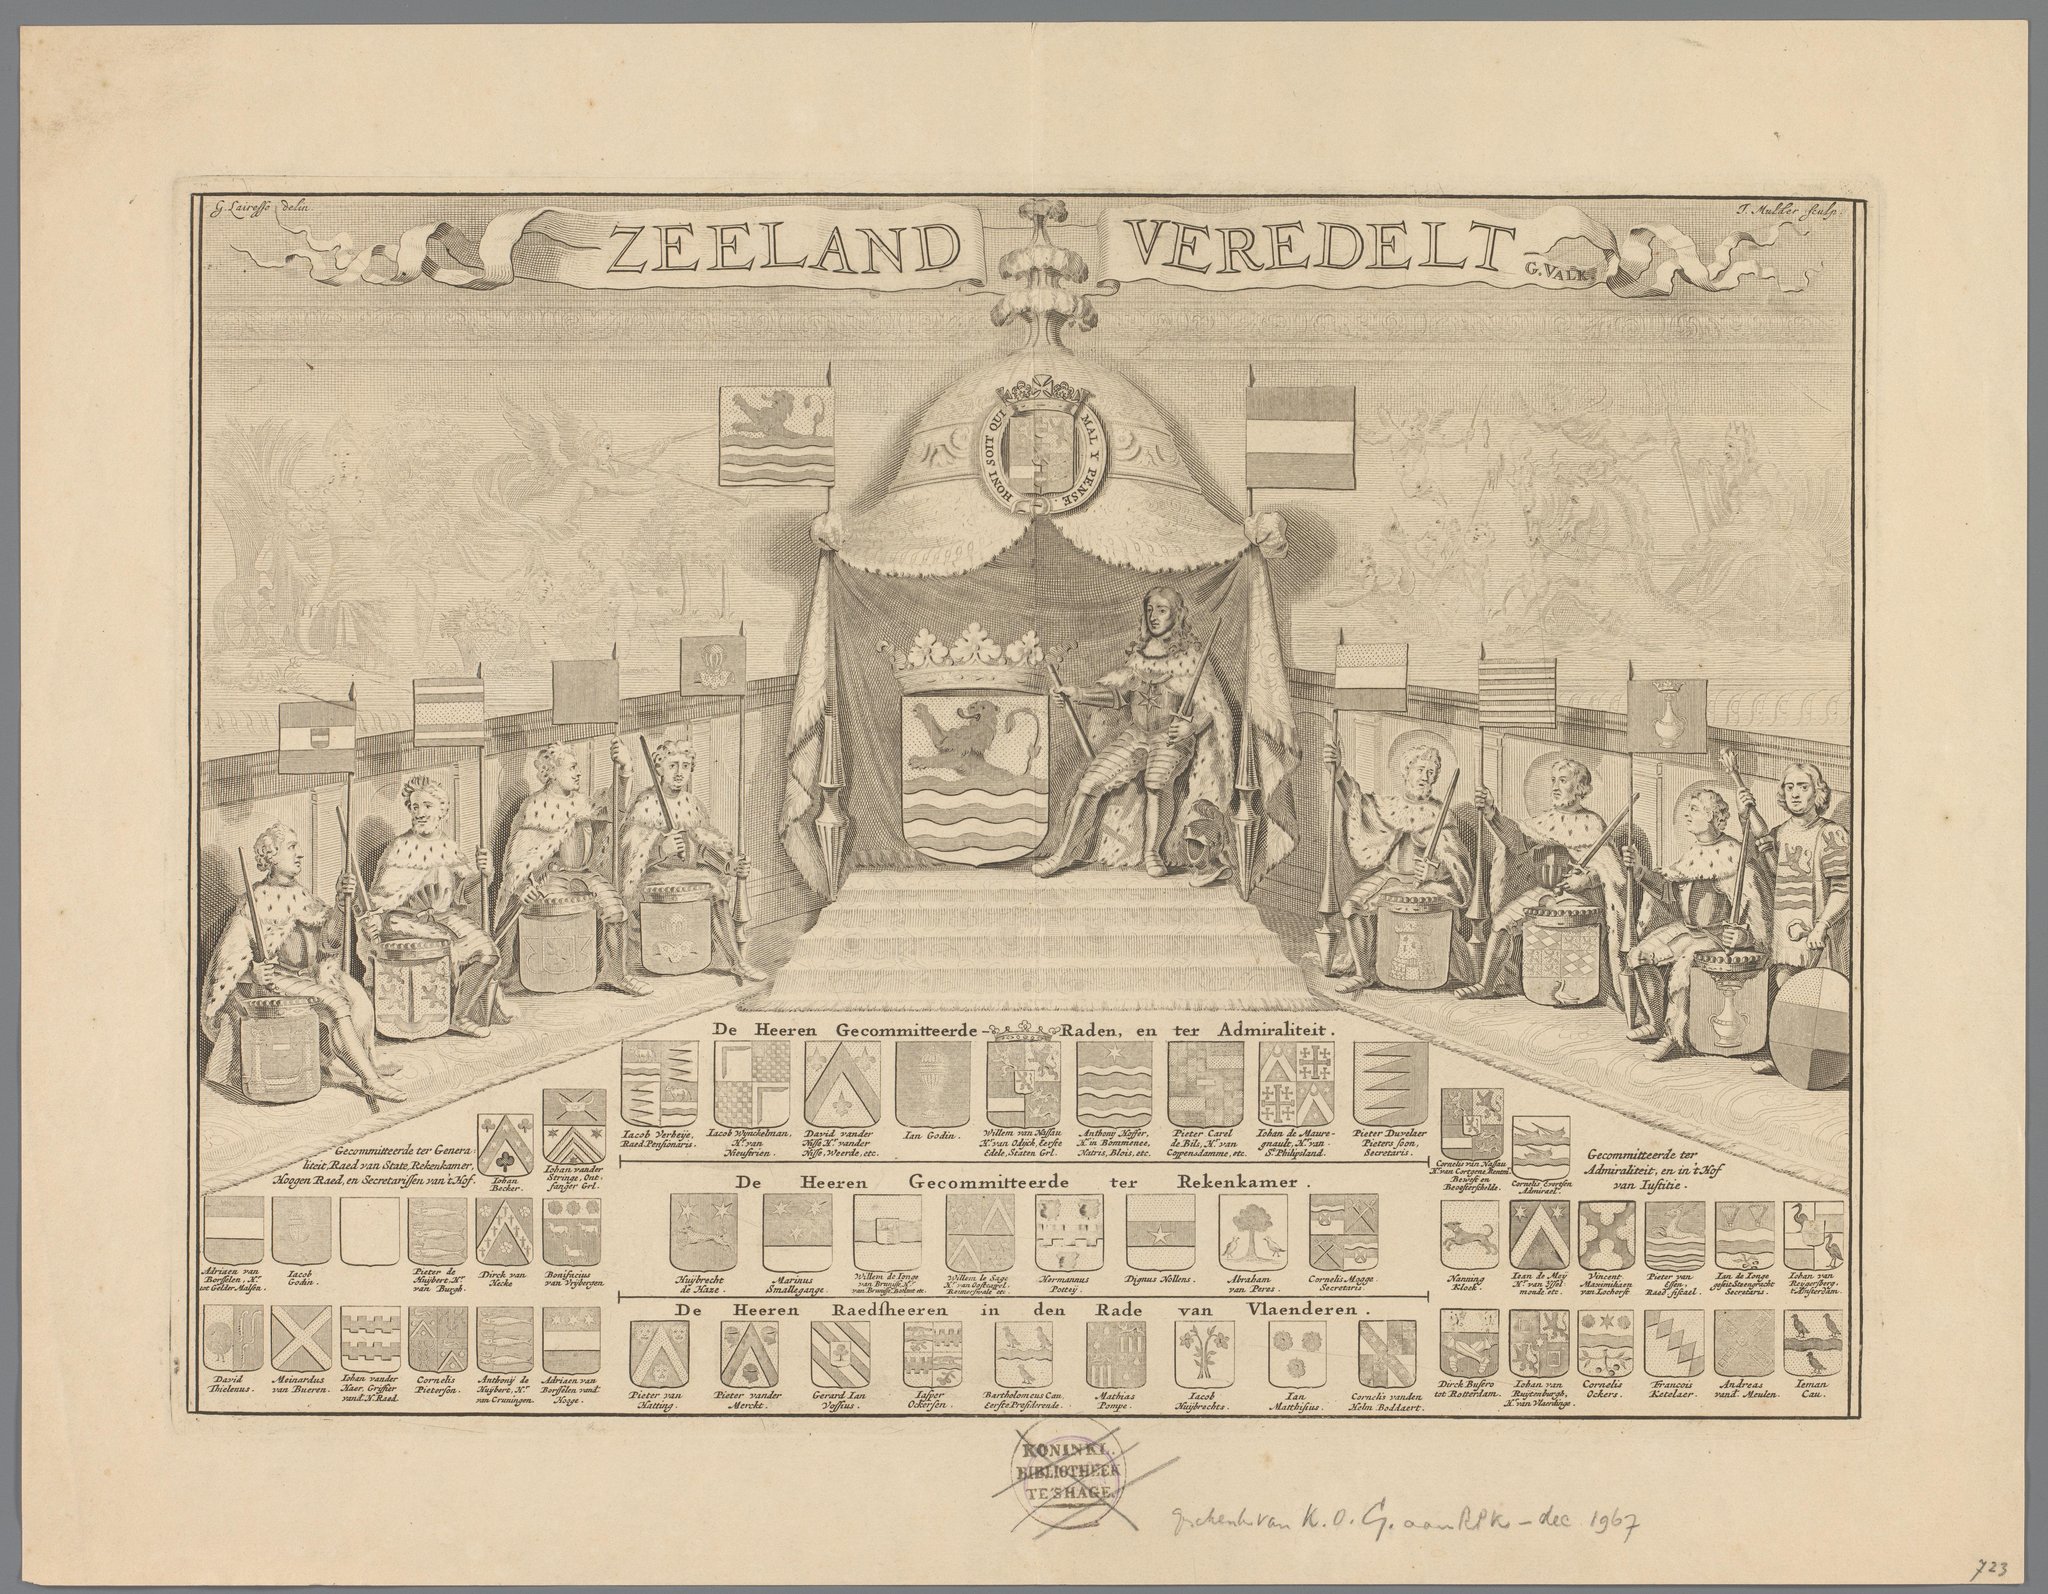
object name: print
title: Wapens en namen van de Gecommitteerde Raden van Zeeland en de steden van Zeeland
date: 1688-1691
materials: paper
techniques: engraving, etching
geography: amsterdam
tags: armorial bearing, heraldry, flag, colours (as symbol of the state, etc.), zeeland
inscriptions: collector's mark: ‘Koninkl. Bibliotheek te 's Hage’, inscription: ‘geschenk van K.O.G. aan RPK-dec 1967’, inscription: ‘Joseph Mulder sc Gerard Valck +1726’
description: Met vlag en wapen representeren zeven mannen de steden van Zeeland. In het midden het wapenschild van Zeeland. Onderaan de wapenschilden van de Gecommitteerde Raden van Zeeland, de admiraliteit, de rekenkamer en de raad van Vlaanderen.